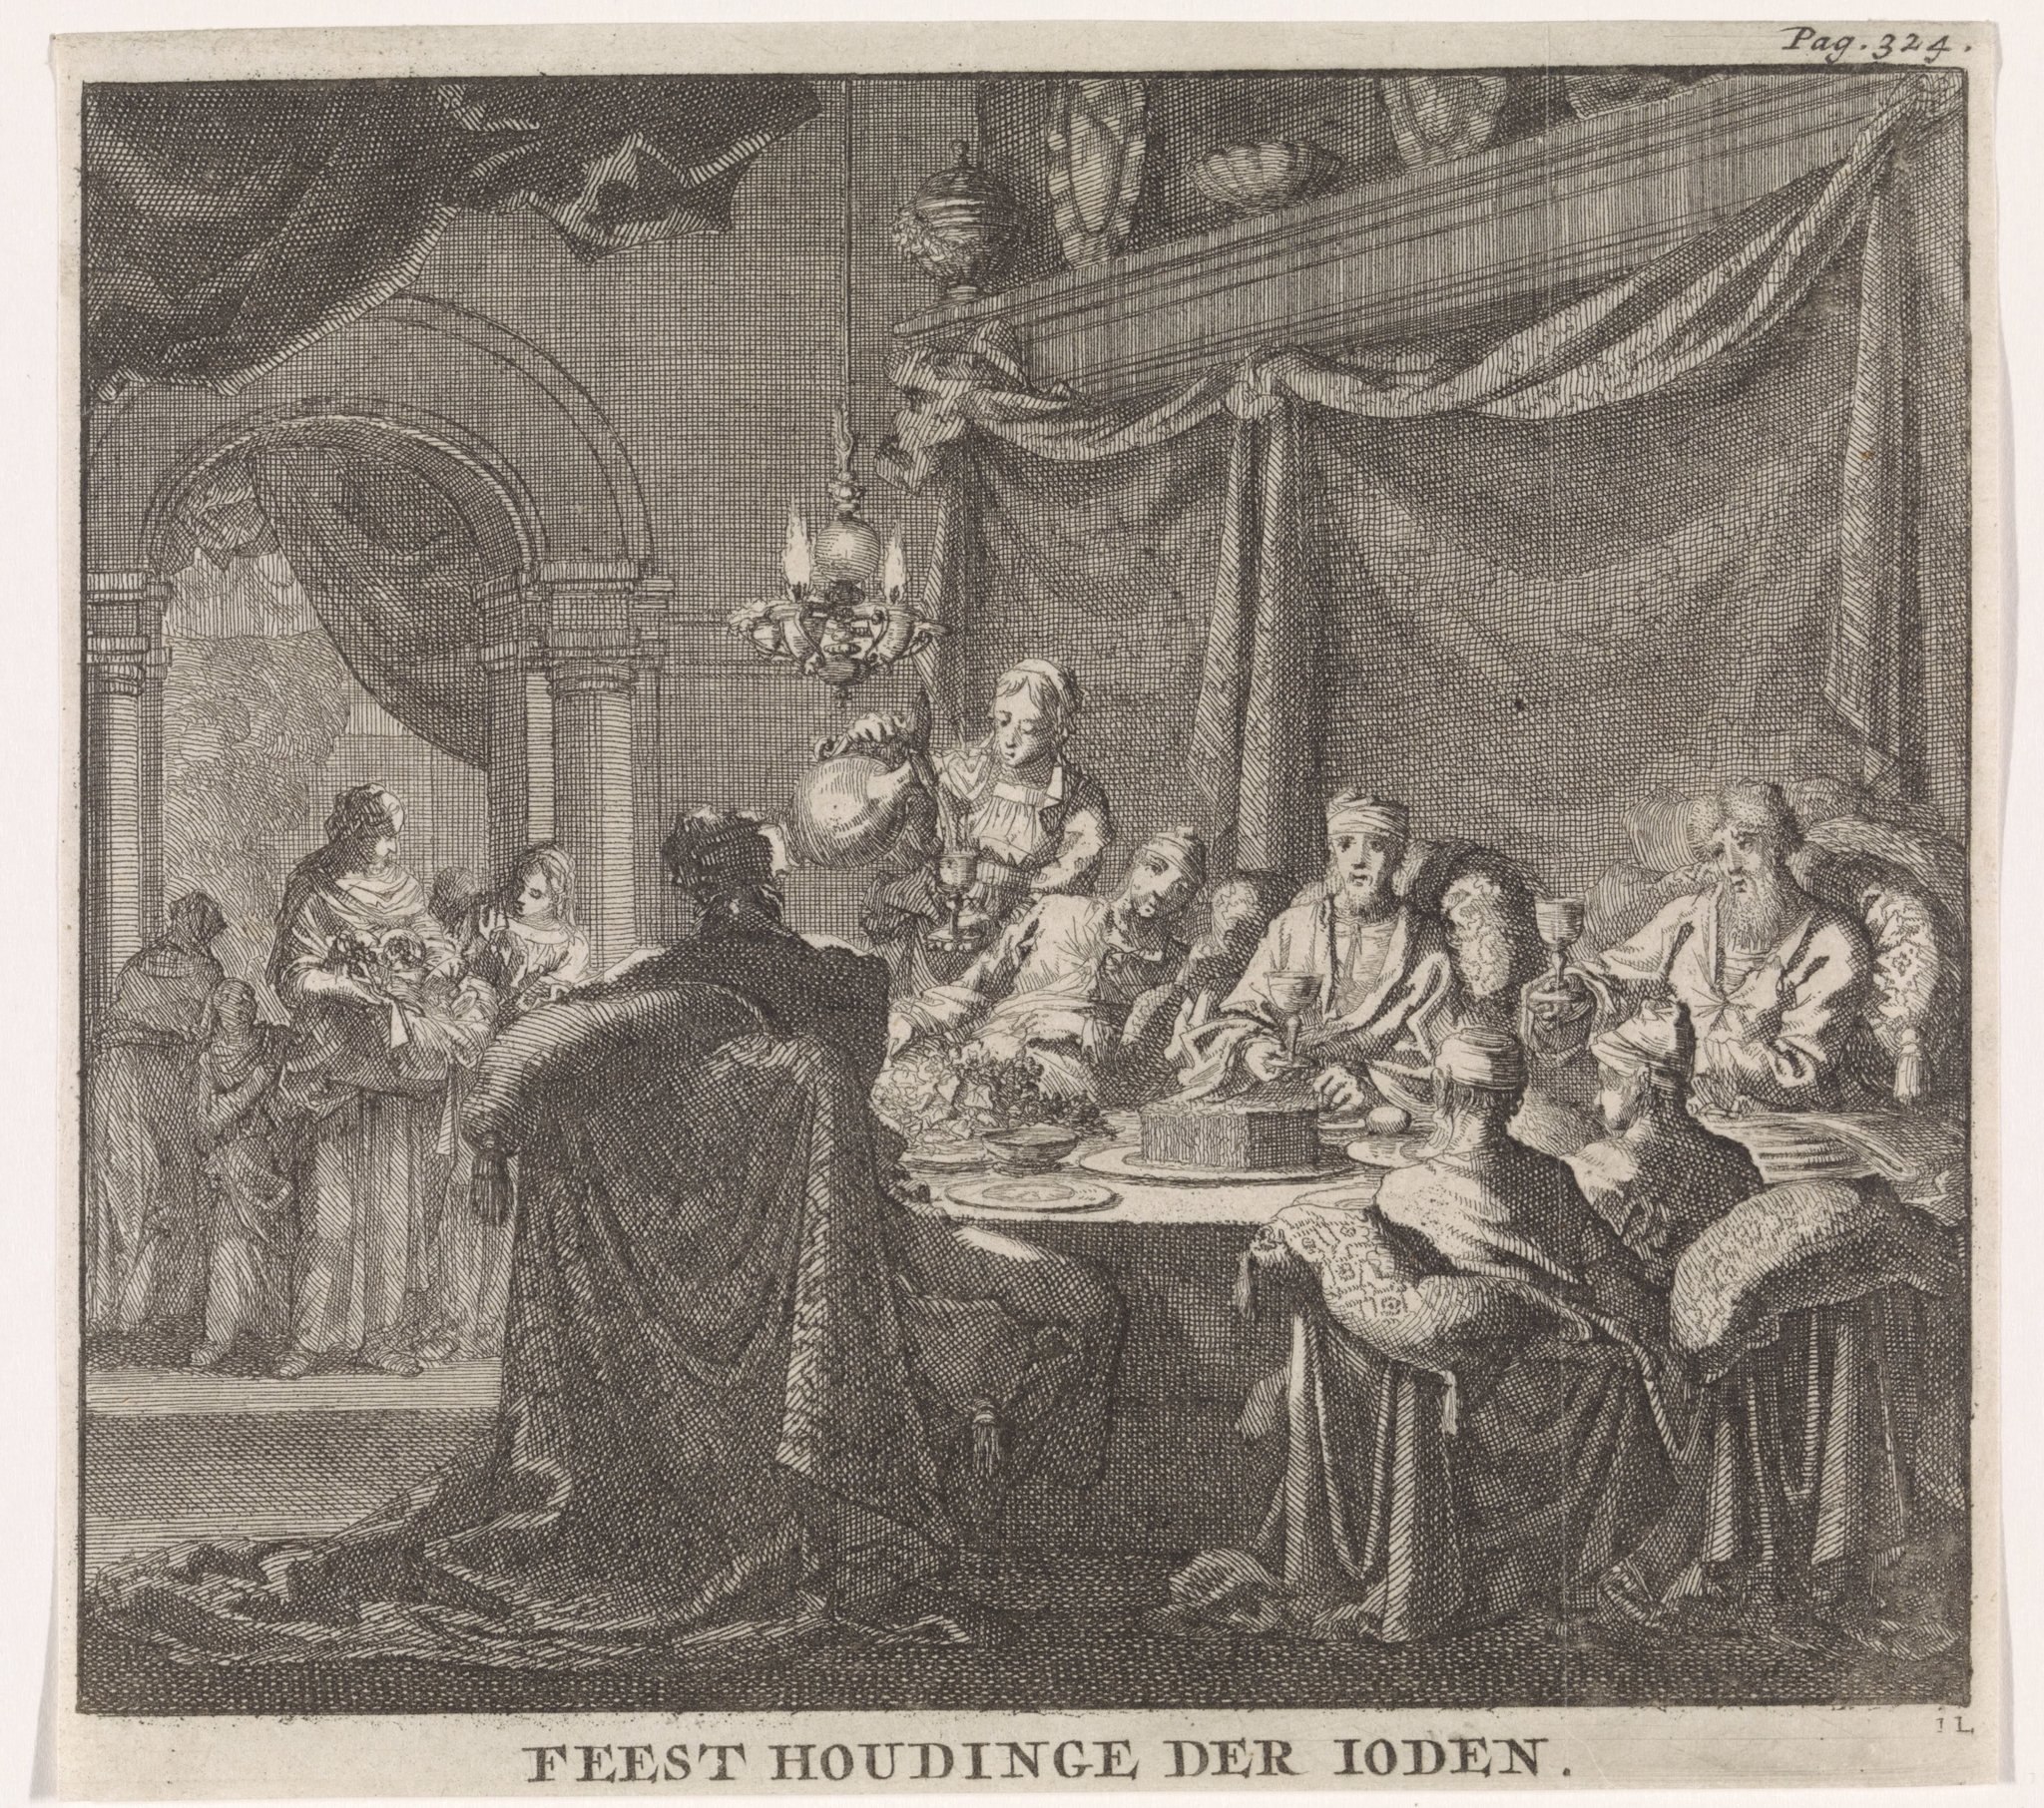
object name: print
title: Feest houdinge der Ioden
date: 1702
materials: paper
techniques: etching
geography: haarlem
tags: 'simhat torah', rejoicing in the law ~ 'sukkot', reading of the torah ~ jewish religion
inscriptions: collector's mark: Lugt 2228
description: Boekillustratie voor Johannes Buxtorf. Schoole der jooden, begrijpende het gehele joodsche geloof. Leiden: Daniel vanden Dalen & Hendrik van Damme, 1702, p. 324.